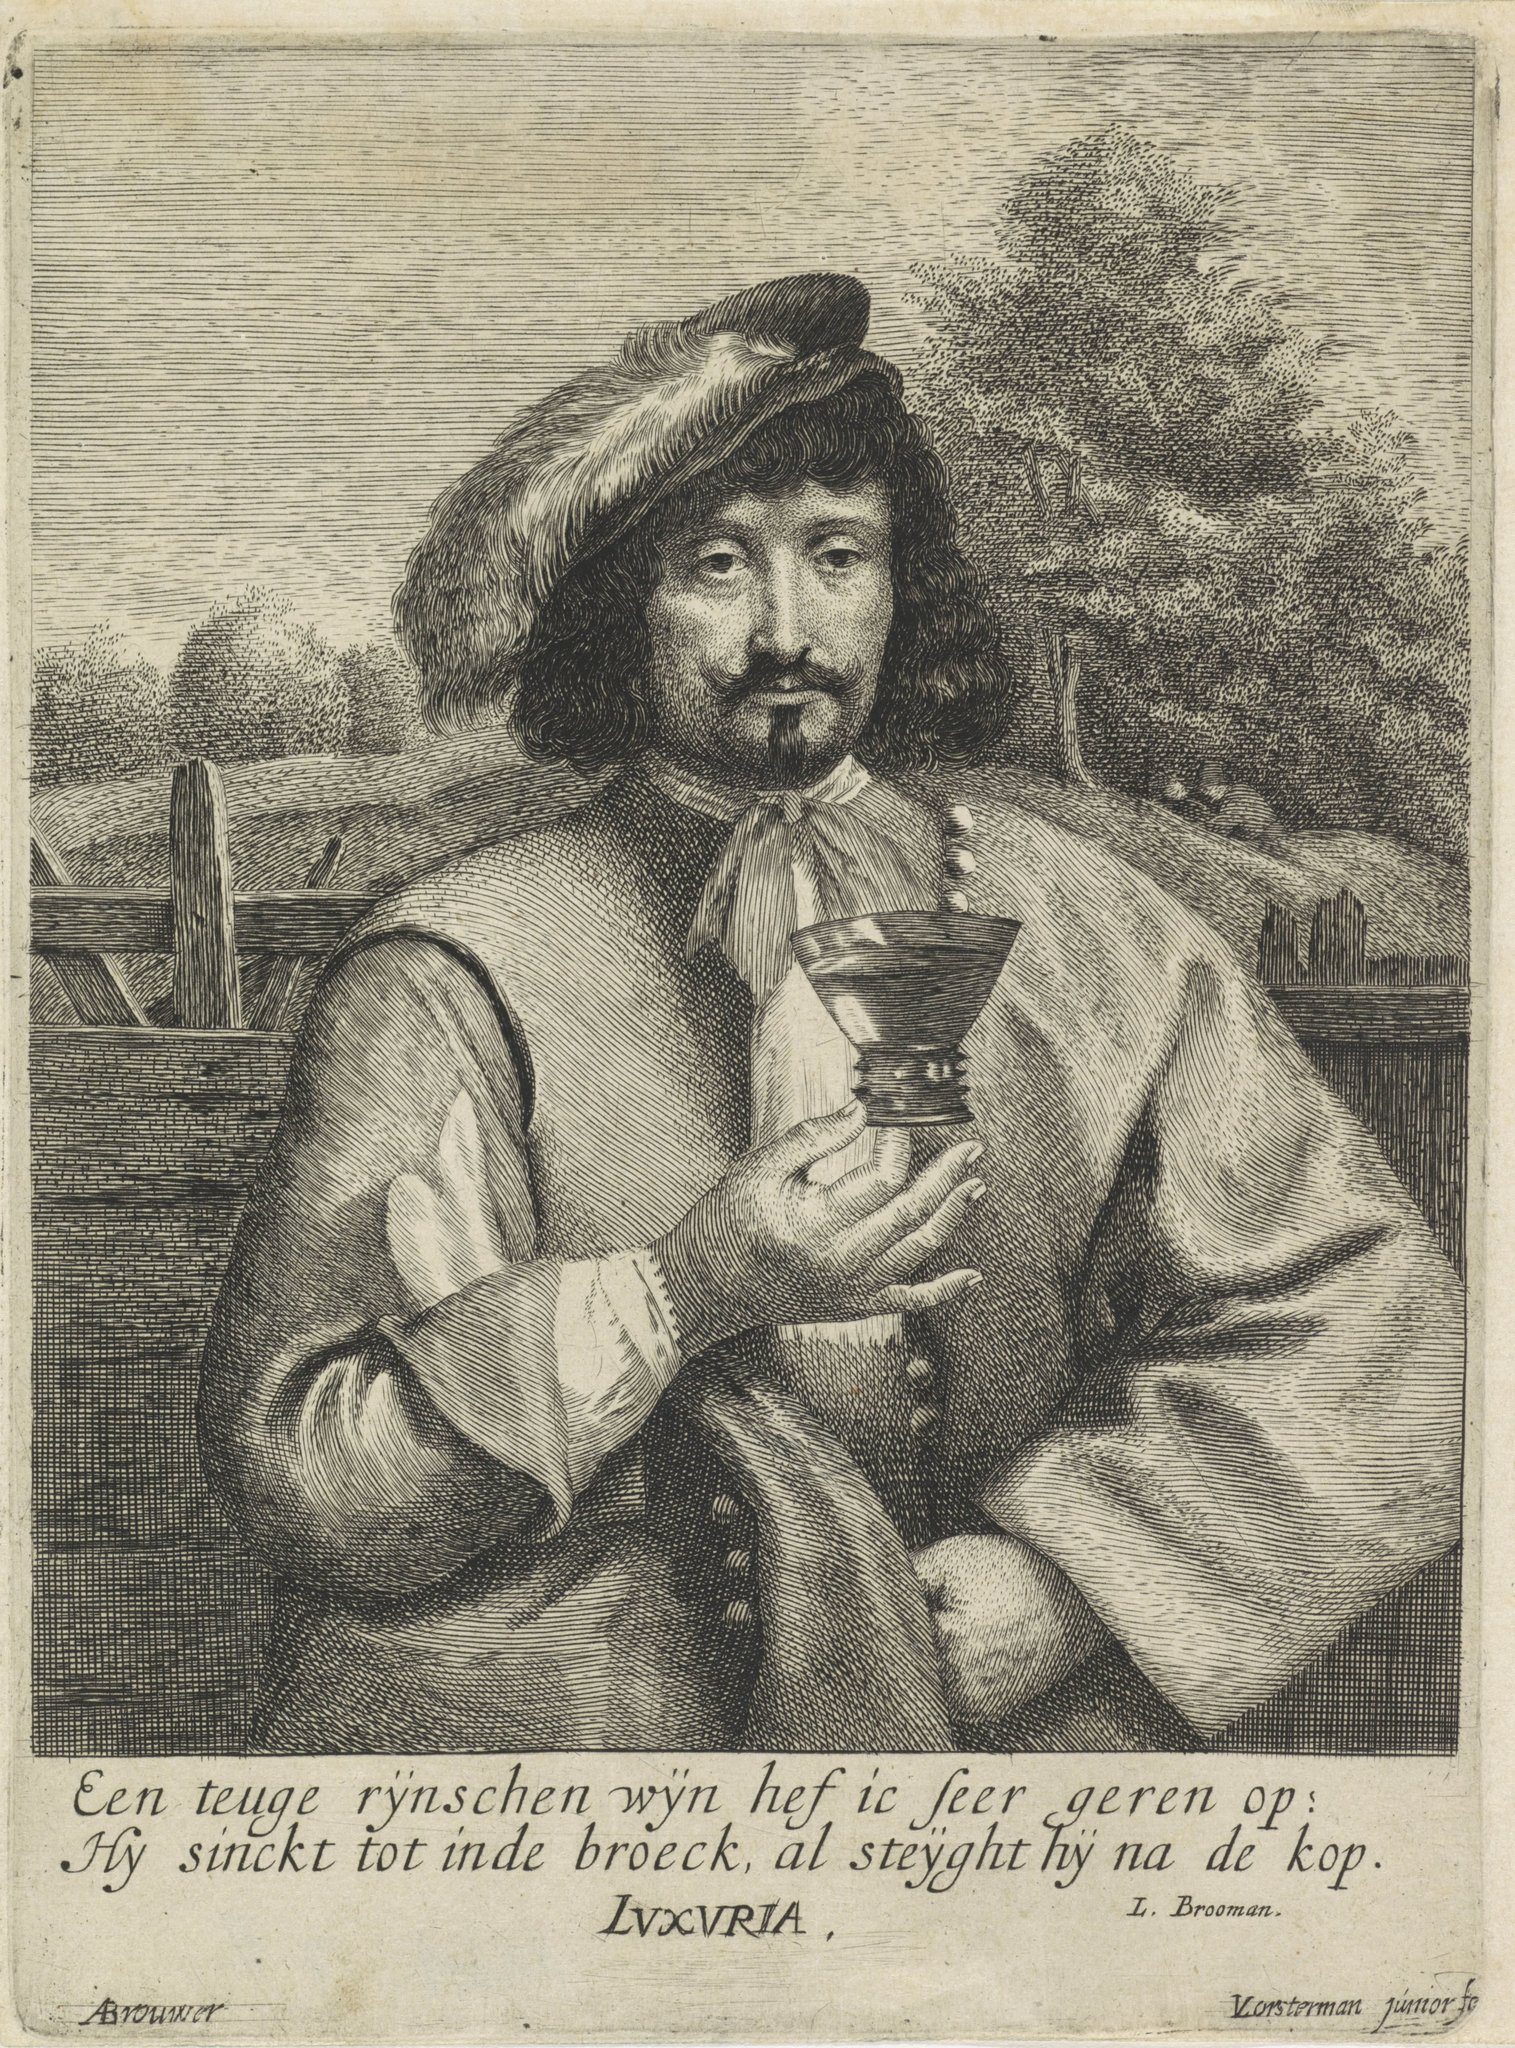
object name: print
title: Man met een wijnglas (Luxuria)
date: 1651-1652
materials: paper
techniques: engraving, etching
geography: antwerp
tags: lust, luxury, 'luxuria'; 'lussuria' (ripa) ~ personification of one of the deadly sins, glass, rummer, glass of wine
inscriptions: collector's mark: Lugt 2760, collector's mark: Lugt 2228